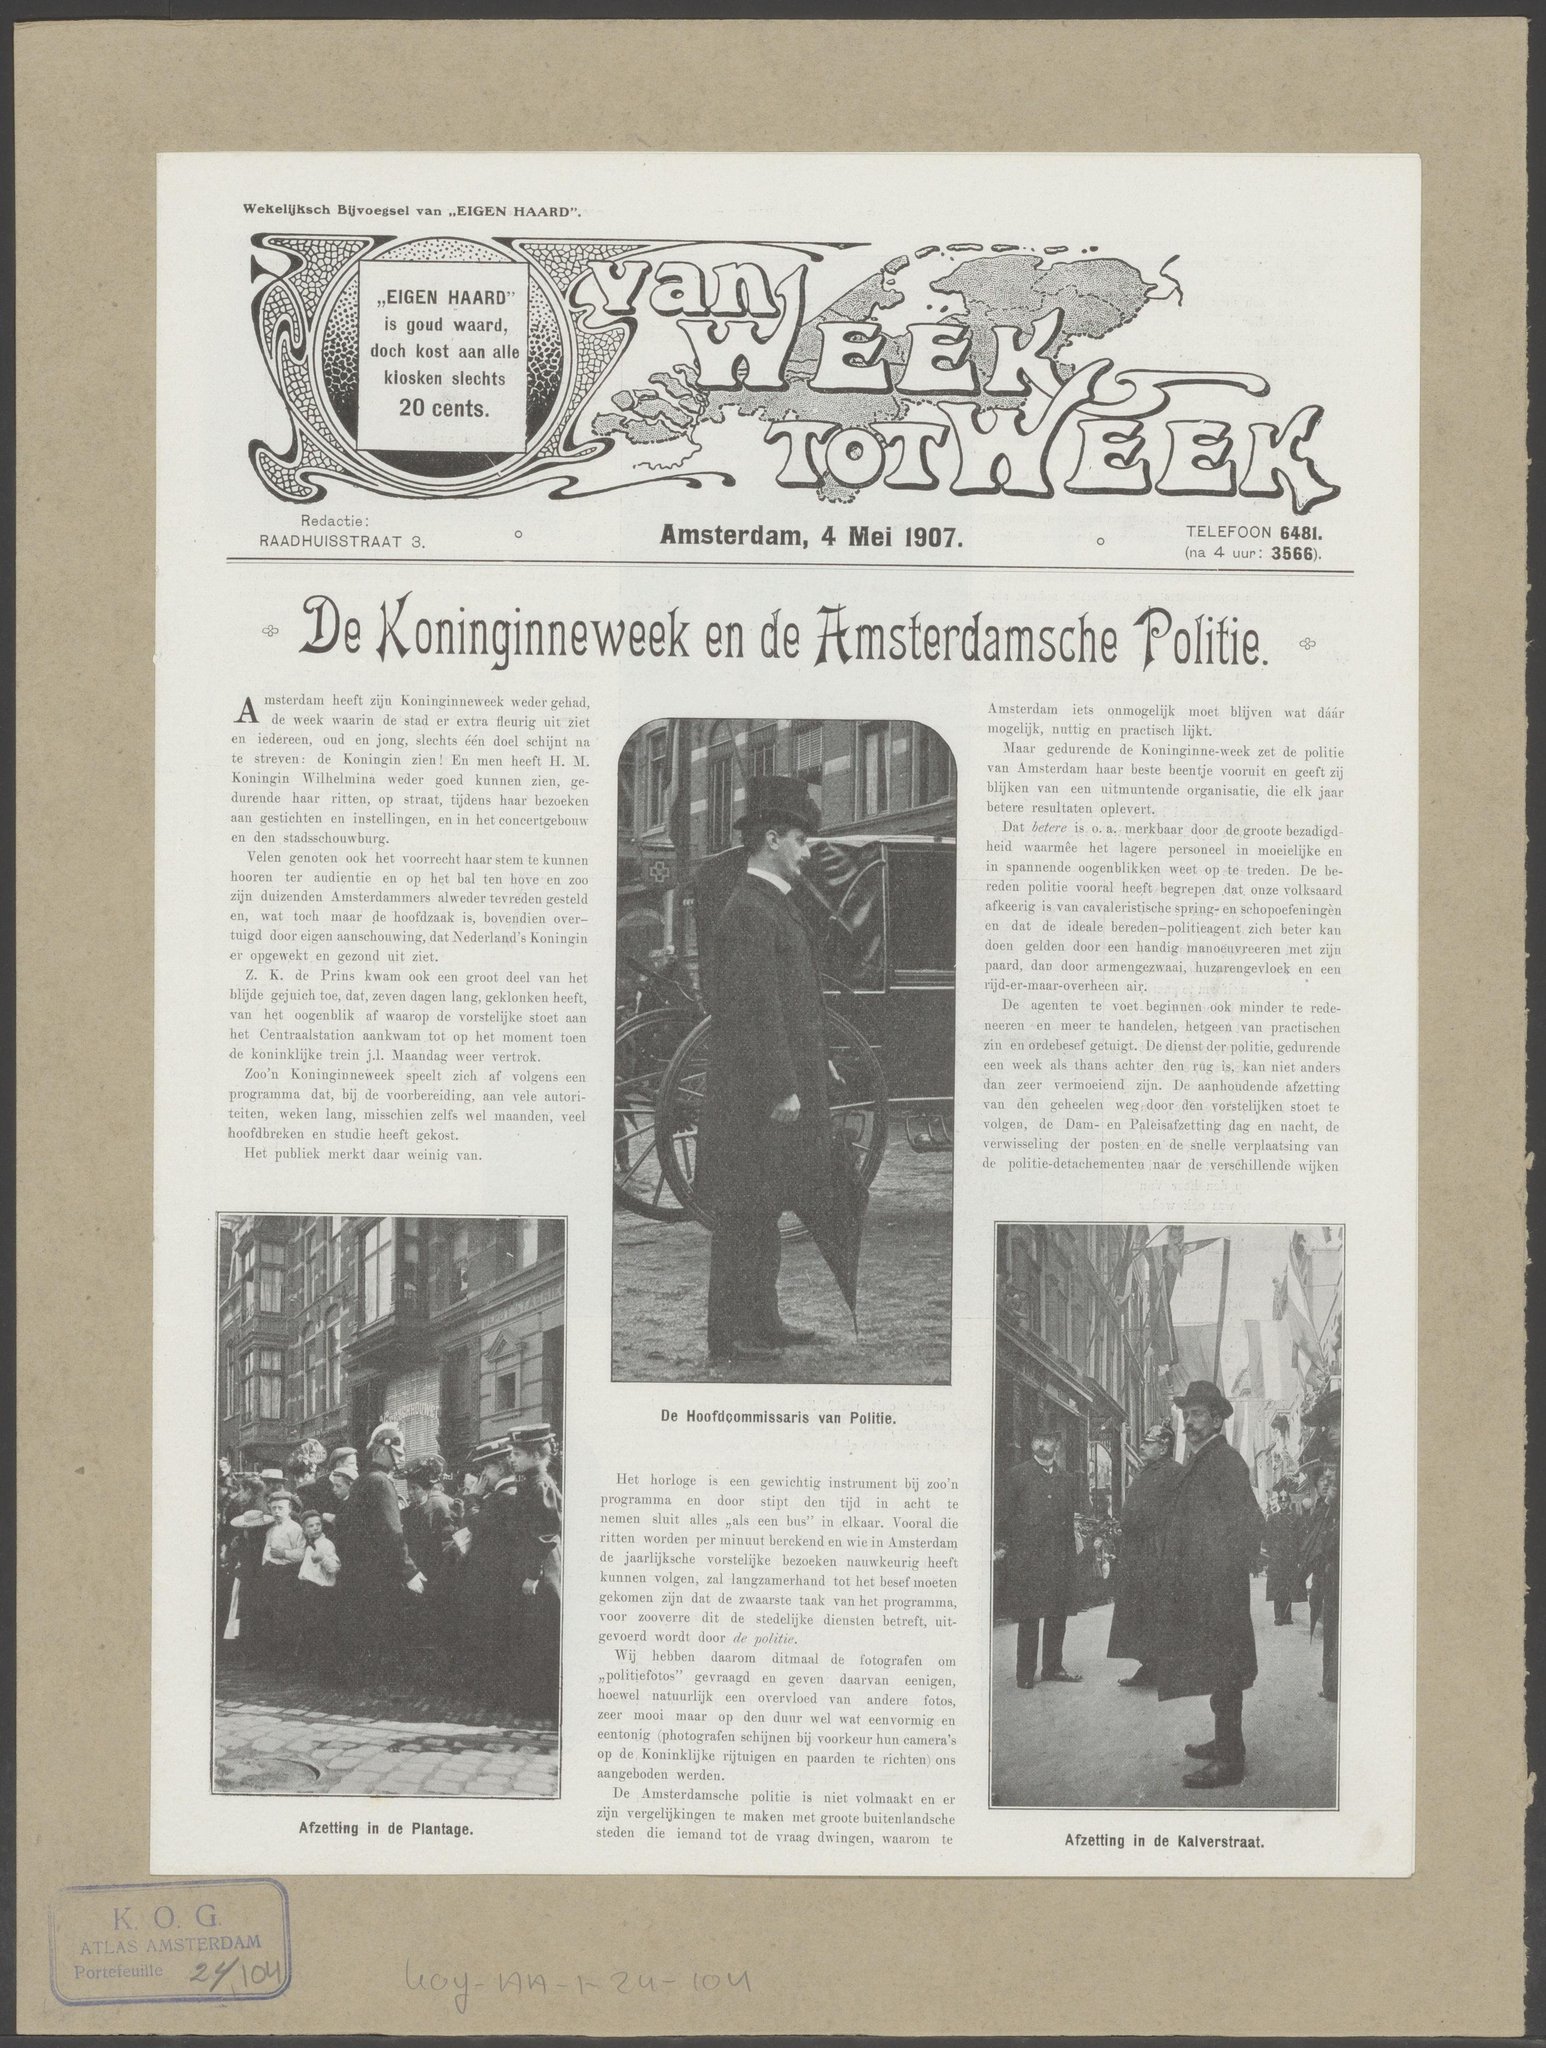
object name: titelblad, titelpagina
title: De Koninginneweek en de Amsterdamsche Politie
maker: Anonymous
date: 1907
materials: paper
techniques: letterpress printing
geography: amsterdam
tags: delft, historical persons, policeman, constable, rejoicing on special occasions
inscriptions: collector's mark: Lugt 1641b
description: Object bestaat uit twee pagina's. Onderwerpsrubriek binnen de Atlas Amsterdam: Politie.